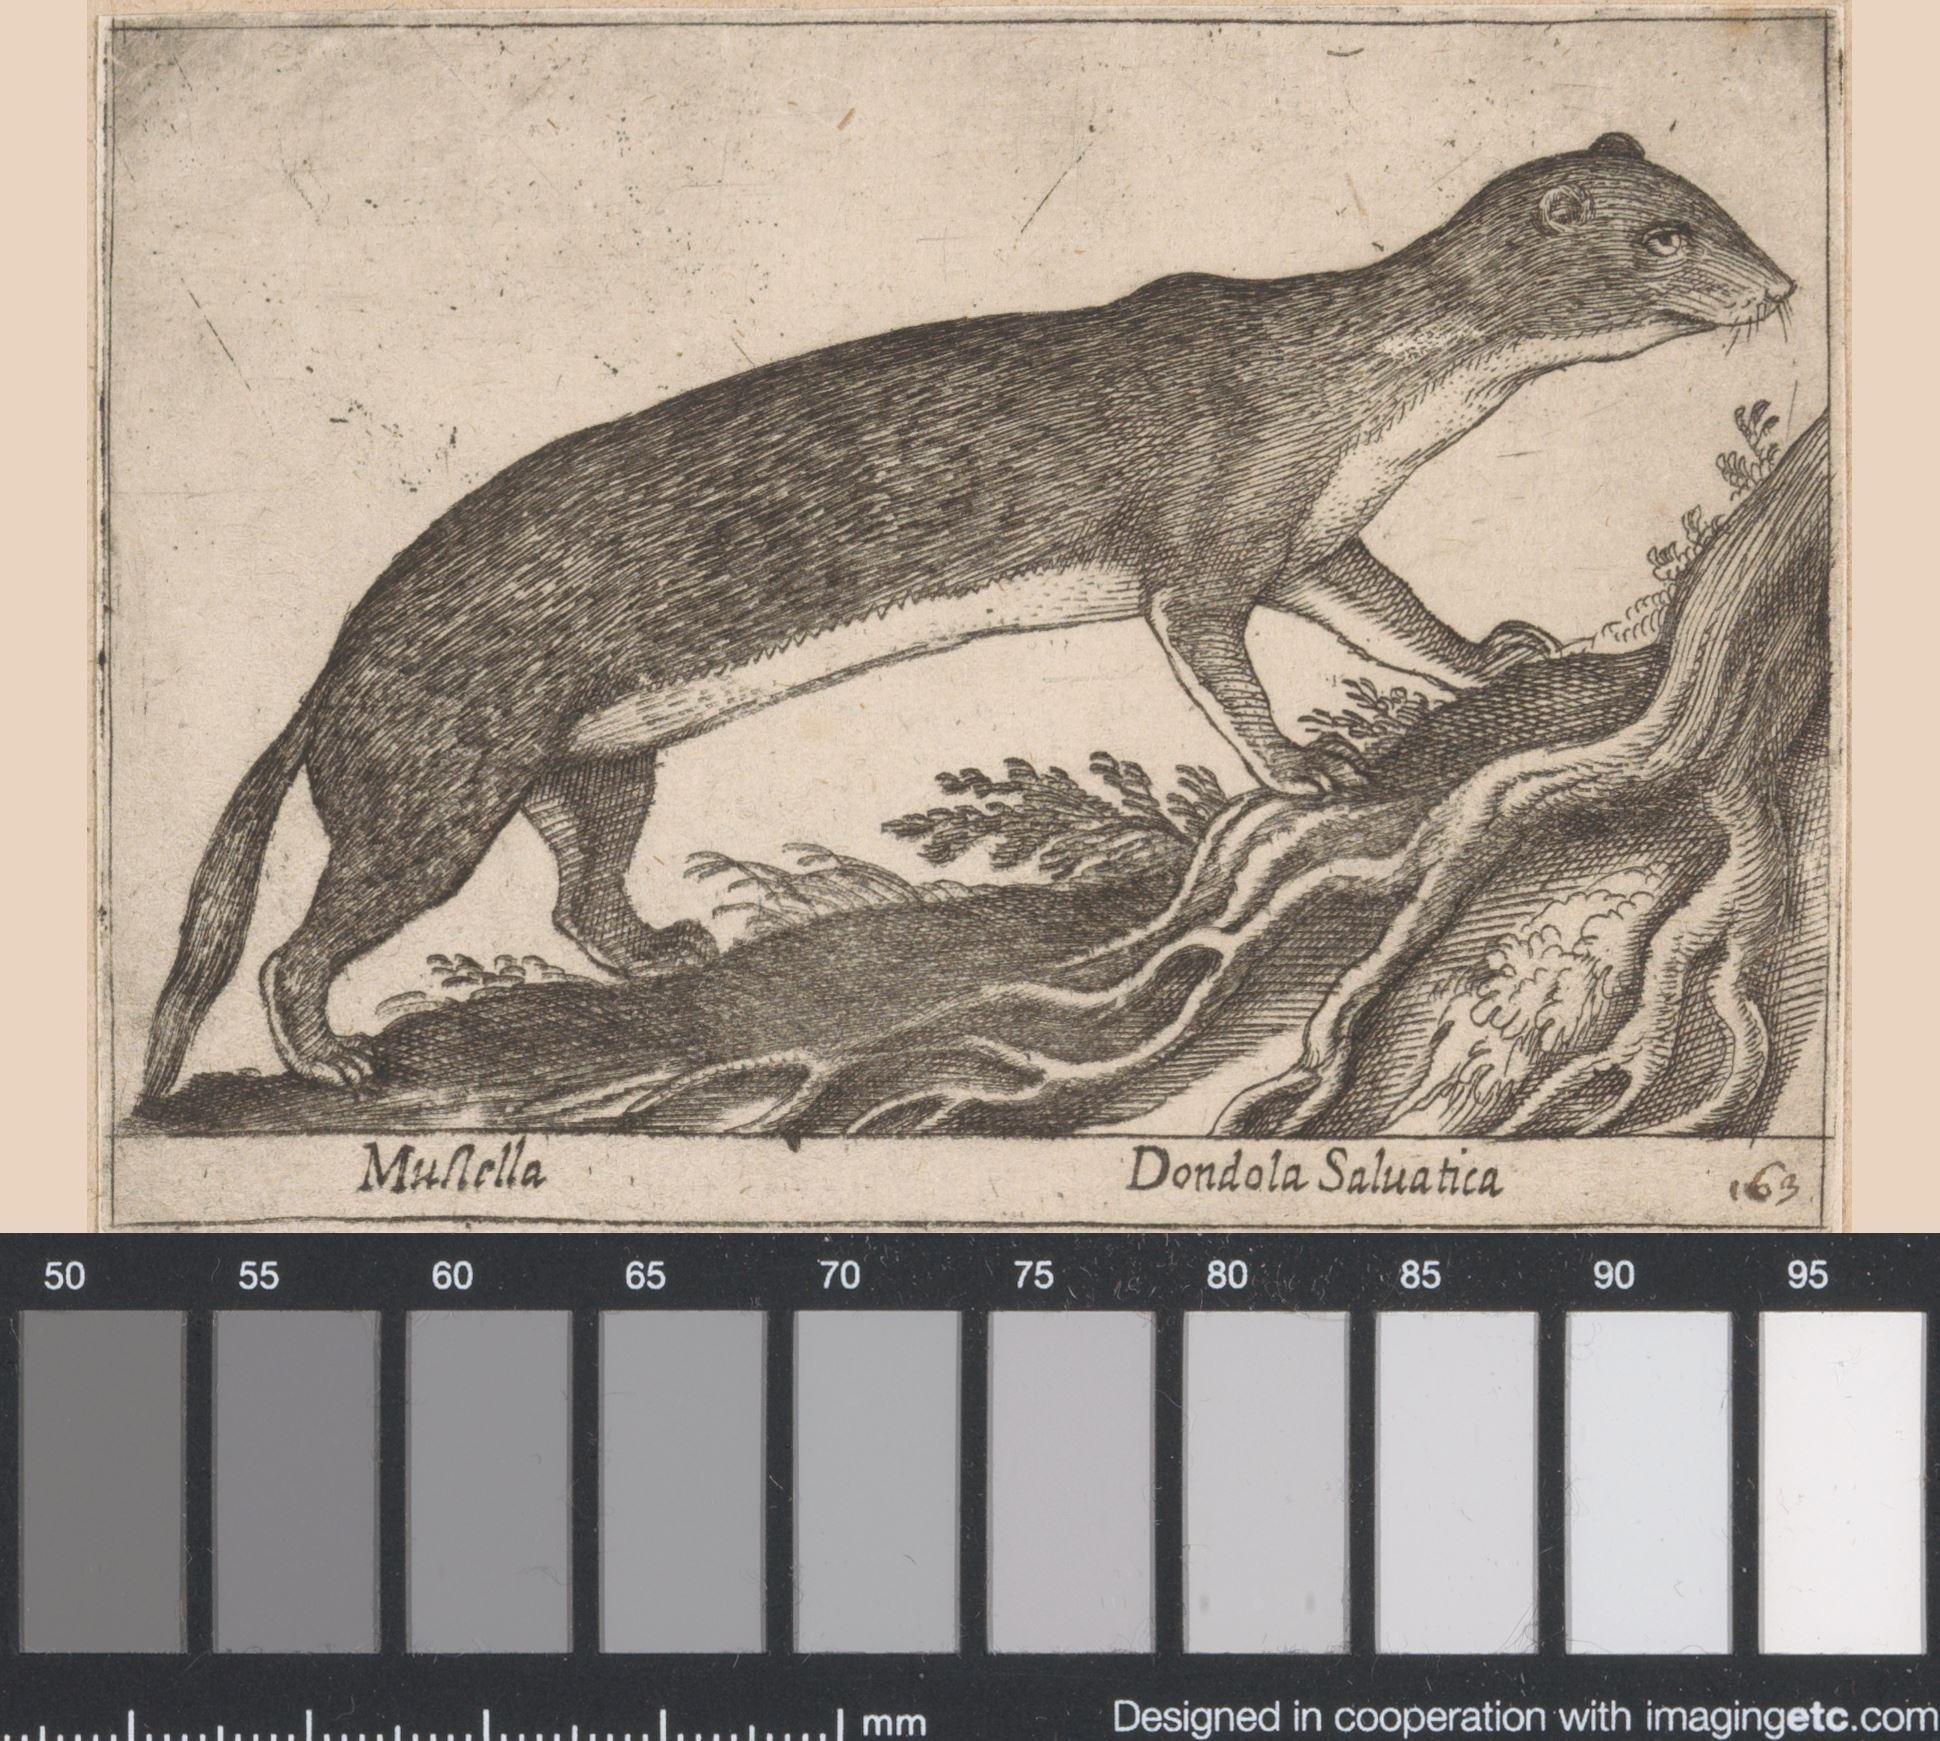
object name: print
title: Nova raccolta de li animali piu curiosi del mondo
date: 1565-1630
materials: paper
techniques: etching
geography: rome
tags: beasts of prey, predatory animals: weasel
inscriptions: collector's mark: Lugt 11, number: ‘163’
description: Deze prent maakt deel uit van een reeks prenten van dieren door Antonio Tempesta. Bekend is dat een tweede staat (met nummering) van deze serie is uitgegeven door Giovanni Giacomo de' Rossi in 1650. Onbekend is wie de eerste staat heeft uitgegeven en wanneer.